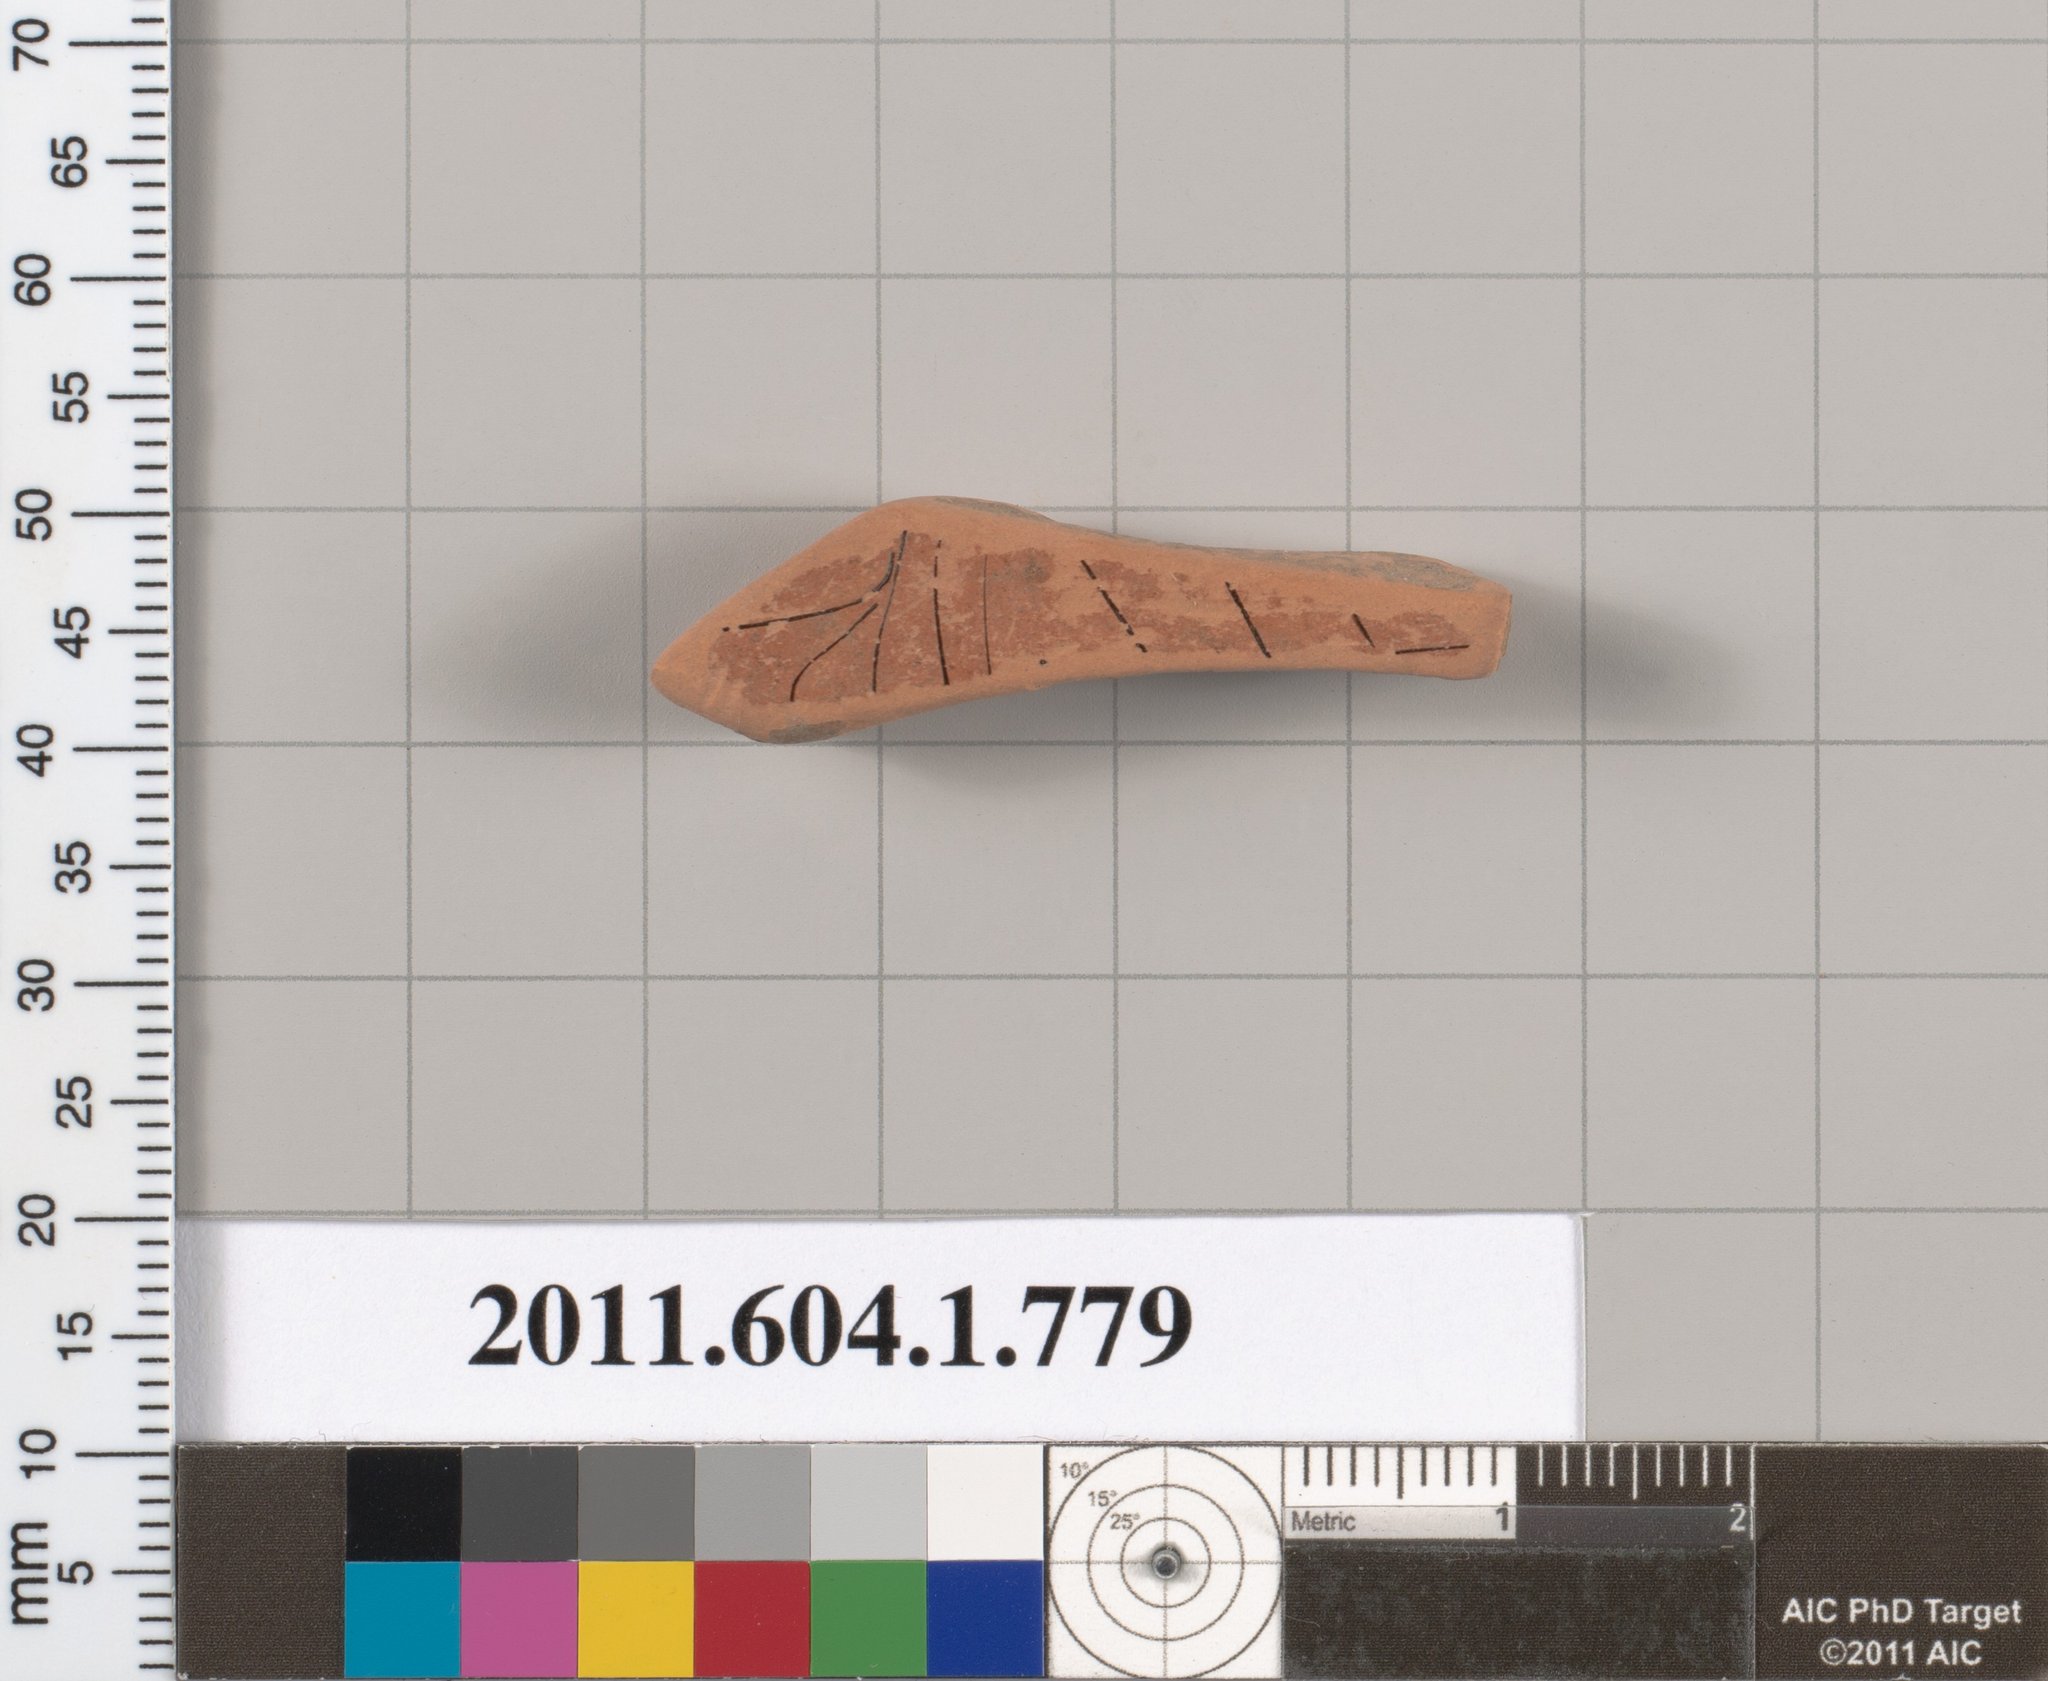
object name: kylix fragment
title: Terracotta fragment of a kylix (drinking cup)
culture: greek, attic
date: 475-451 BCE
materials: terracotta